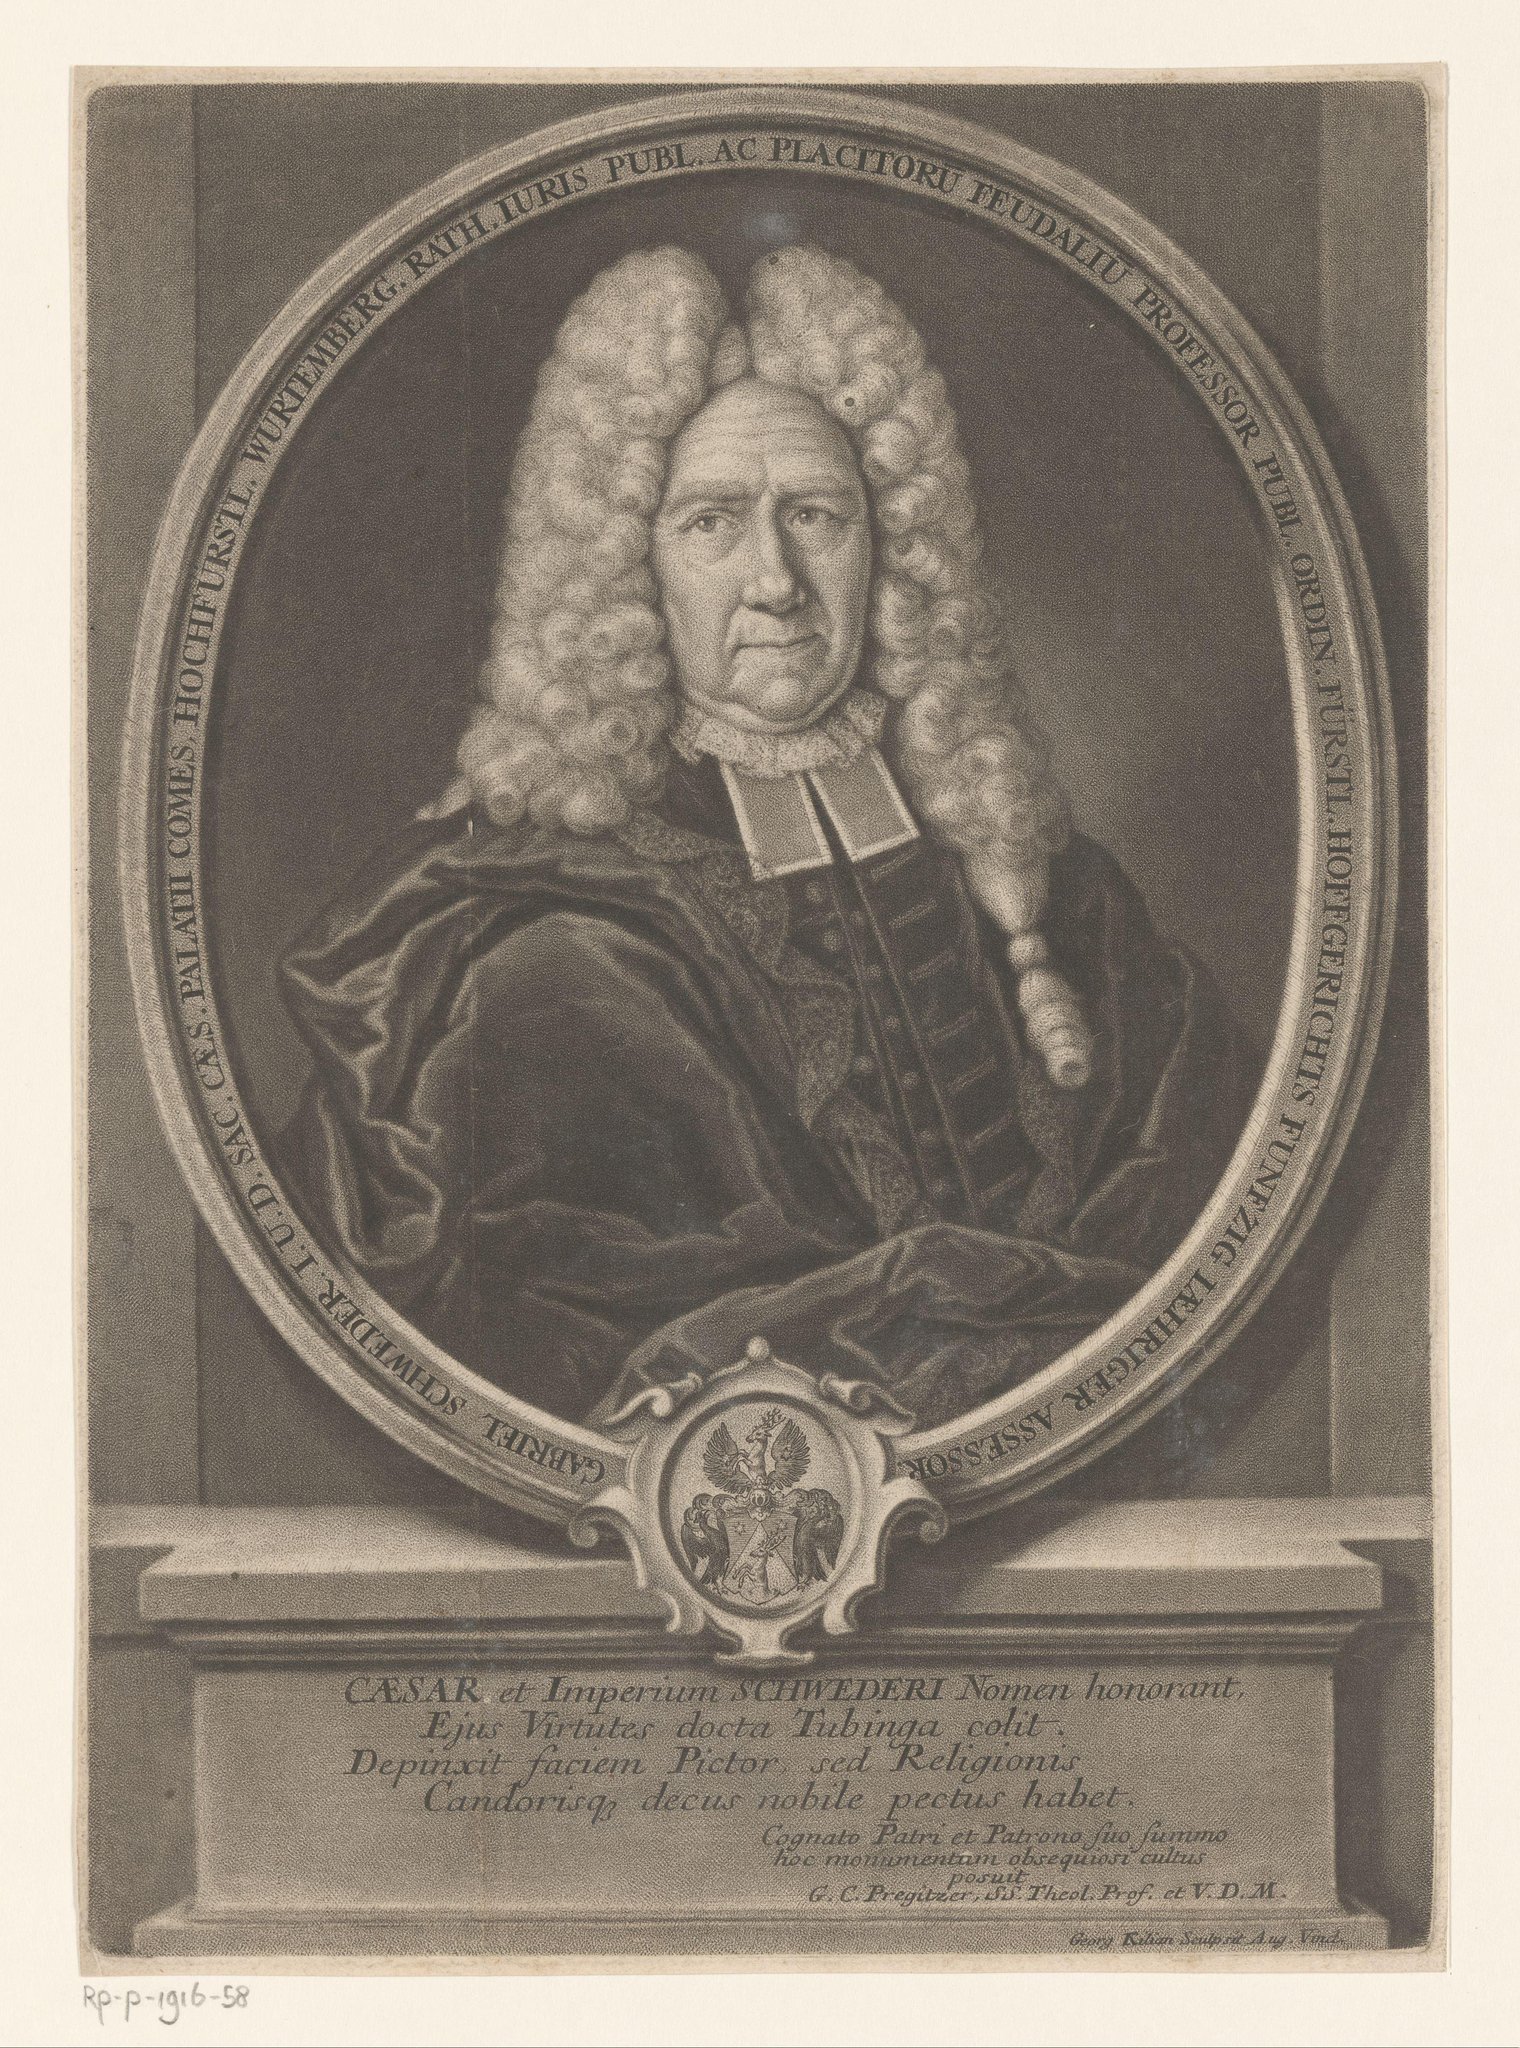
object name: print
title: Portret van Gabriel Schweder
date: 1693-1735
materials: paper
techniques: etching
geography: augsburg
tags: historical persons, armorial bearing, heraldry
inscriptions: collector's mark: Lugt 2228